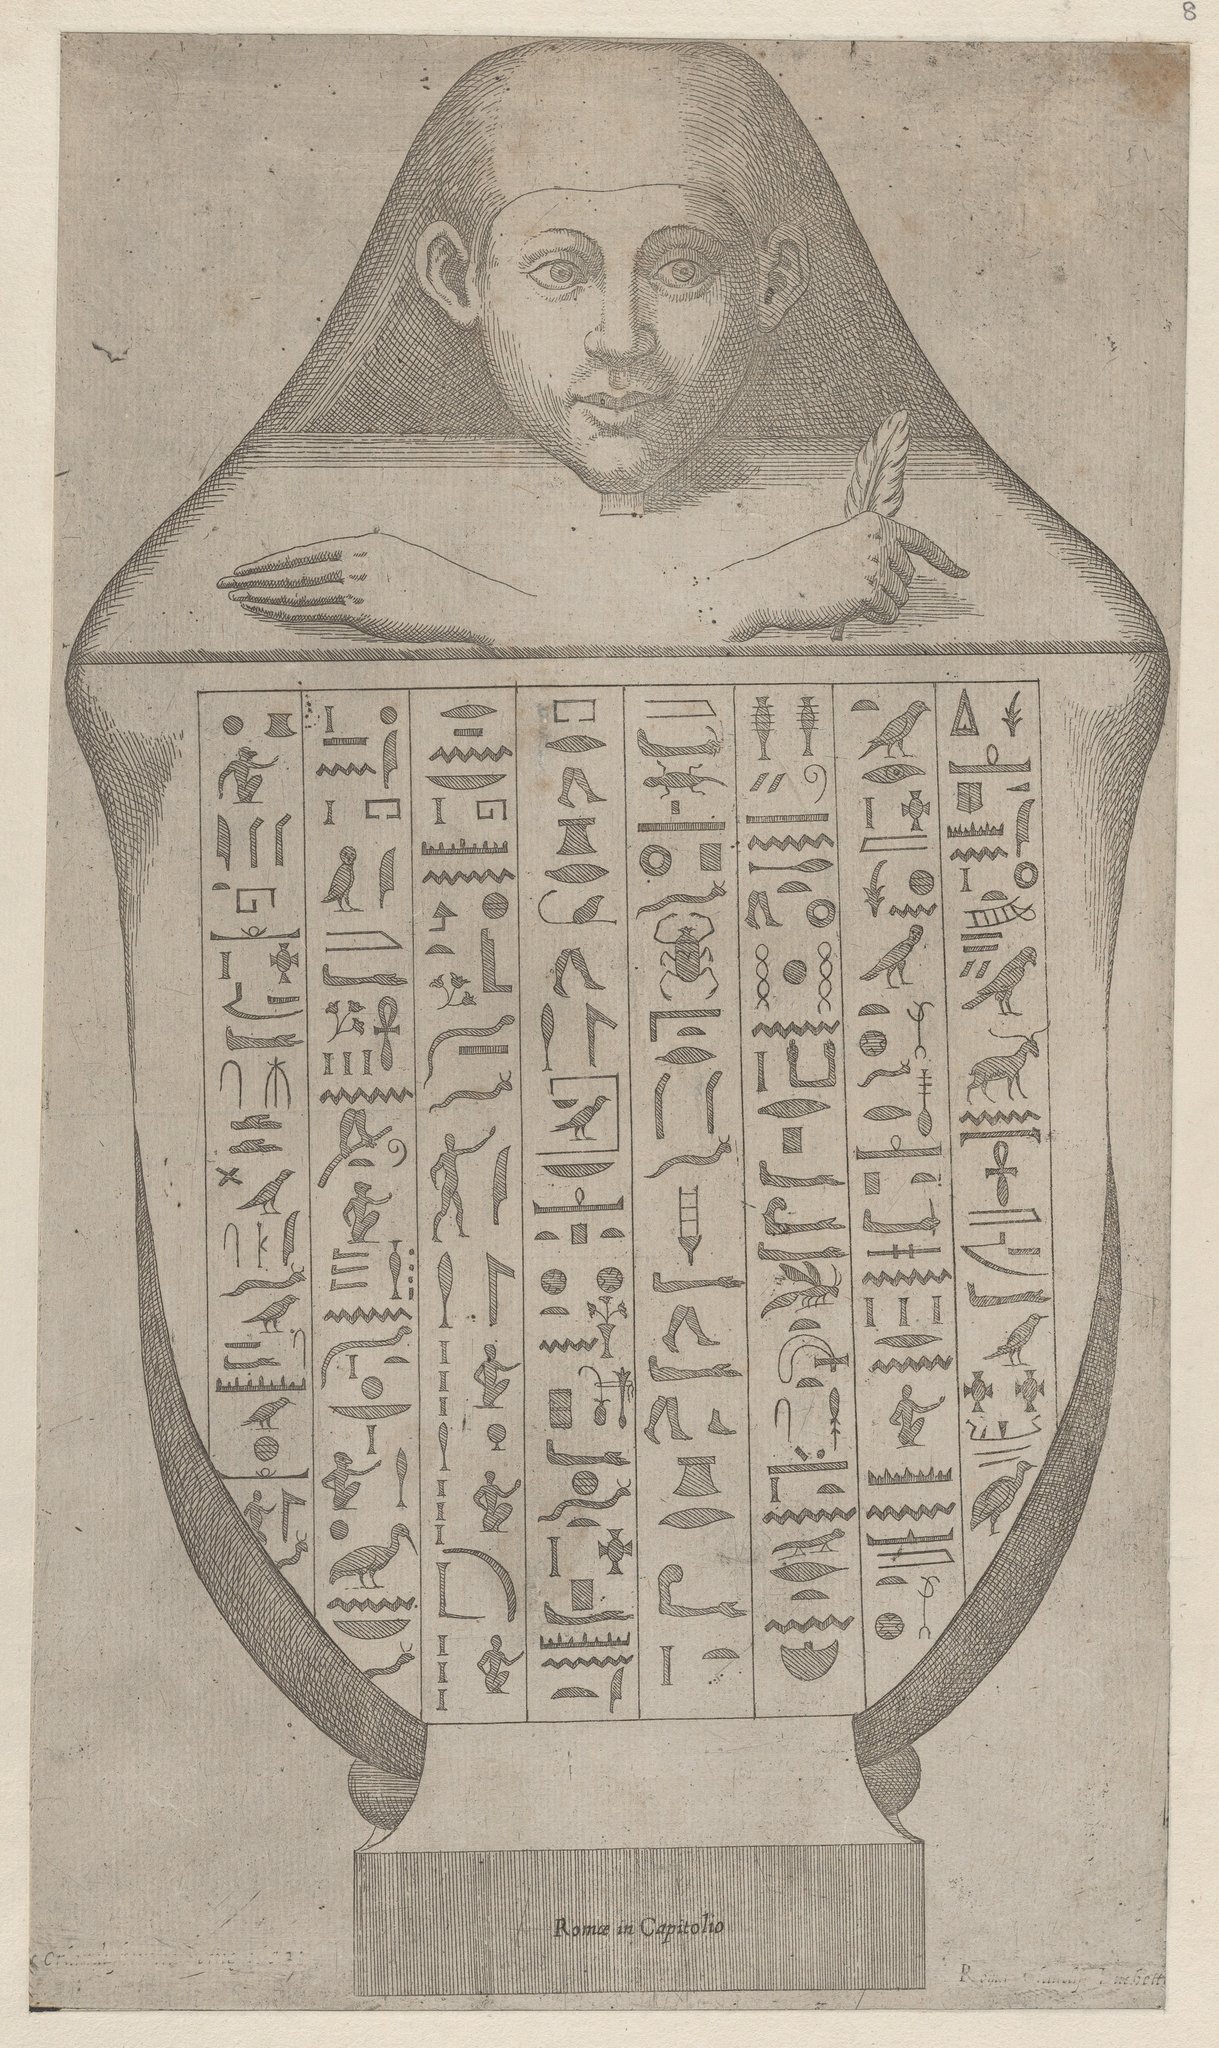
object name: print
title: Face of an Egyptian canopic vase, from "Speculum Romanae Magnificentiae"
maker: etienne dupérac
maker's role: artist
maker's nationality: french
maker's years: 1535-1604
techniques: etching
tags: faces,hands,hieroglyphs